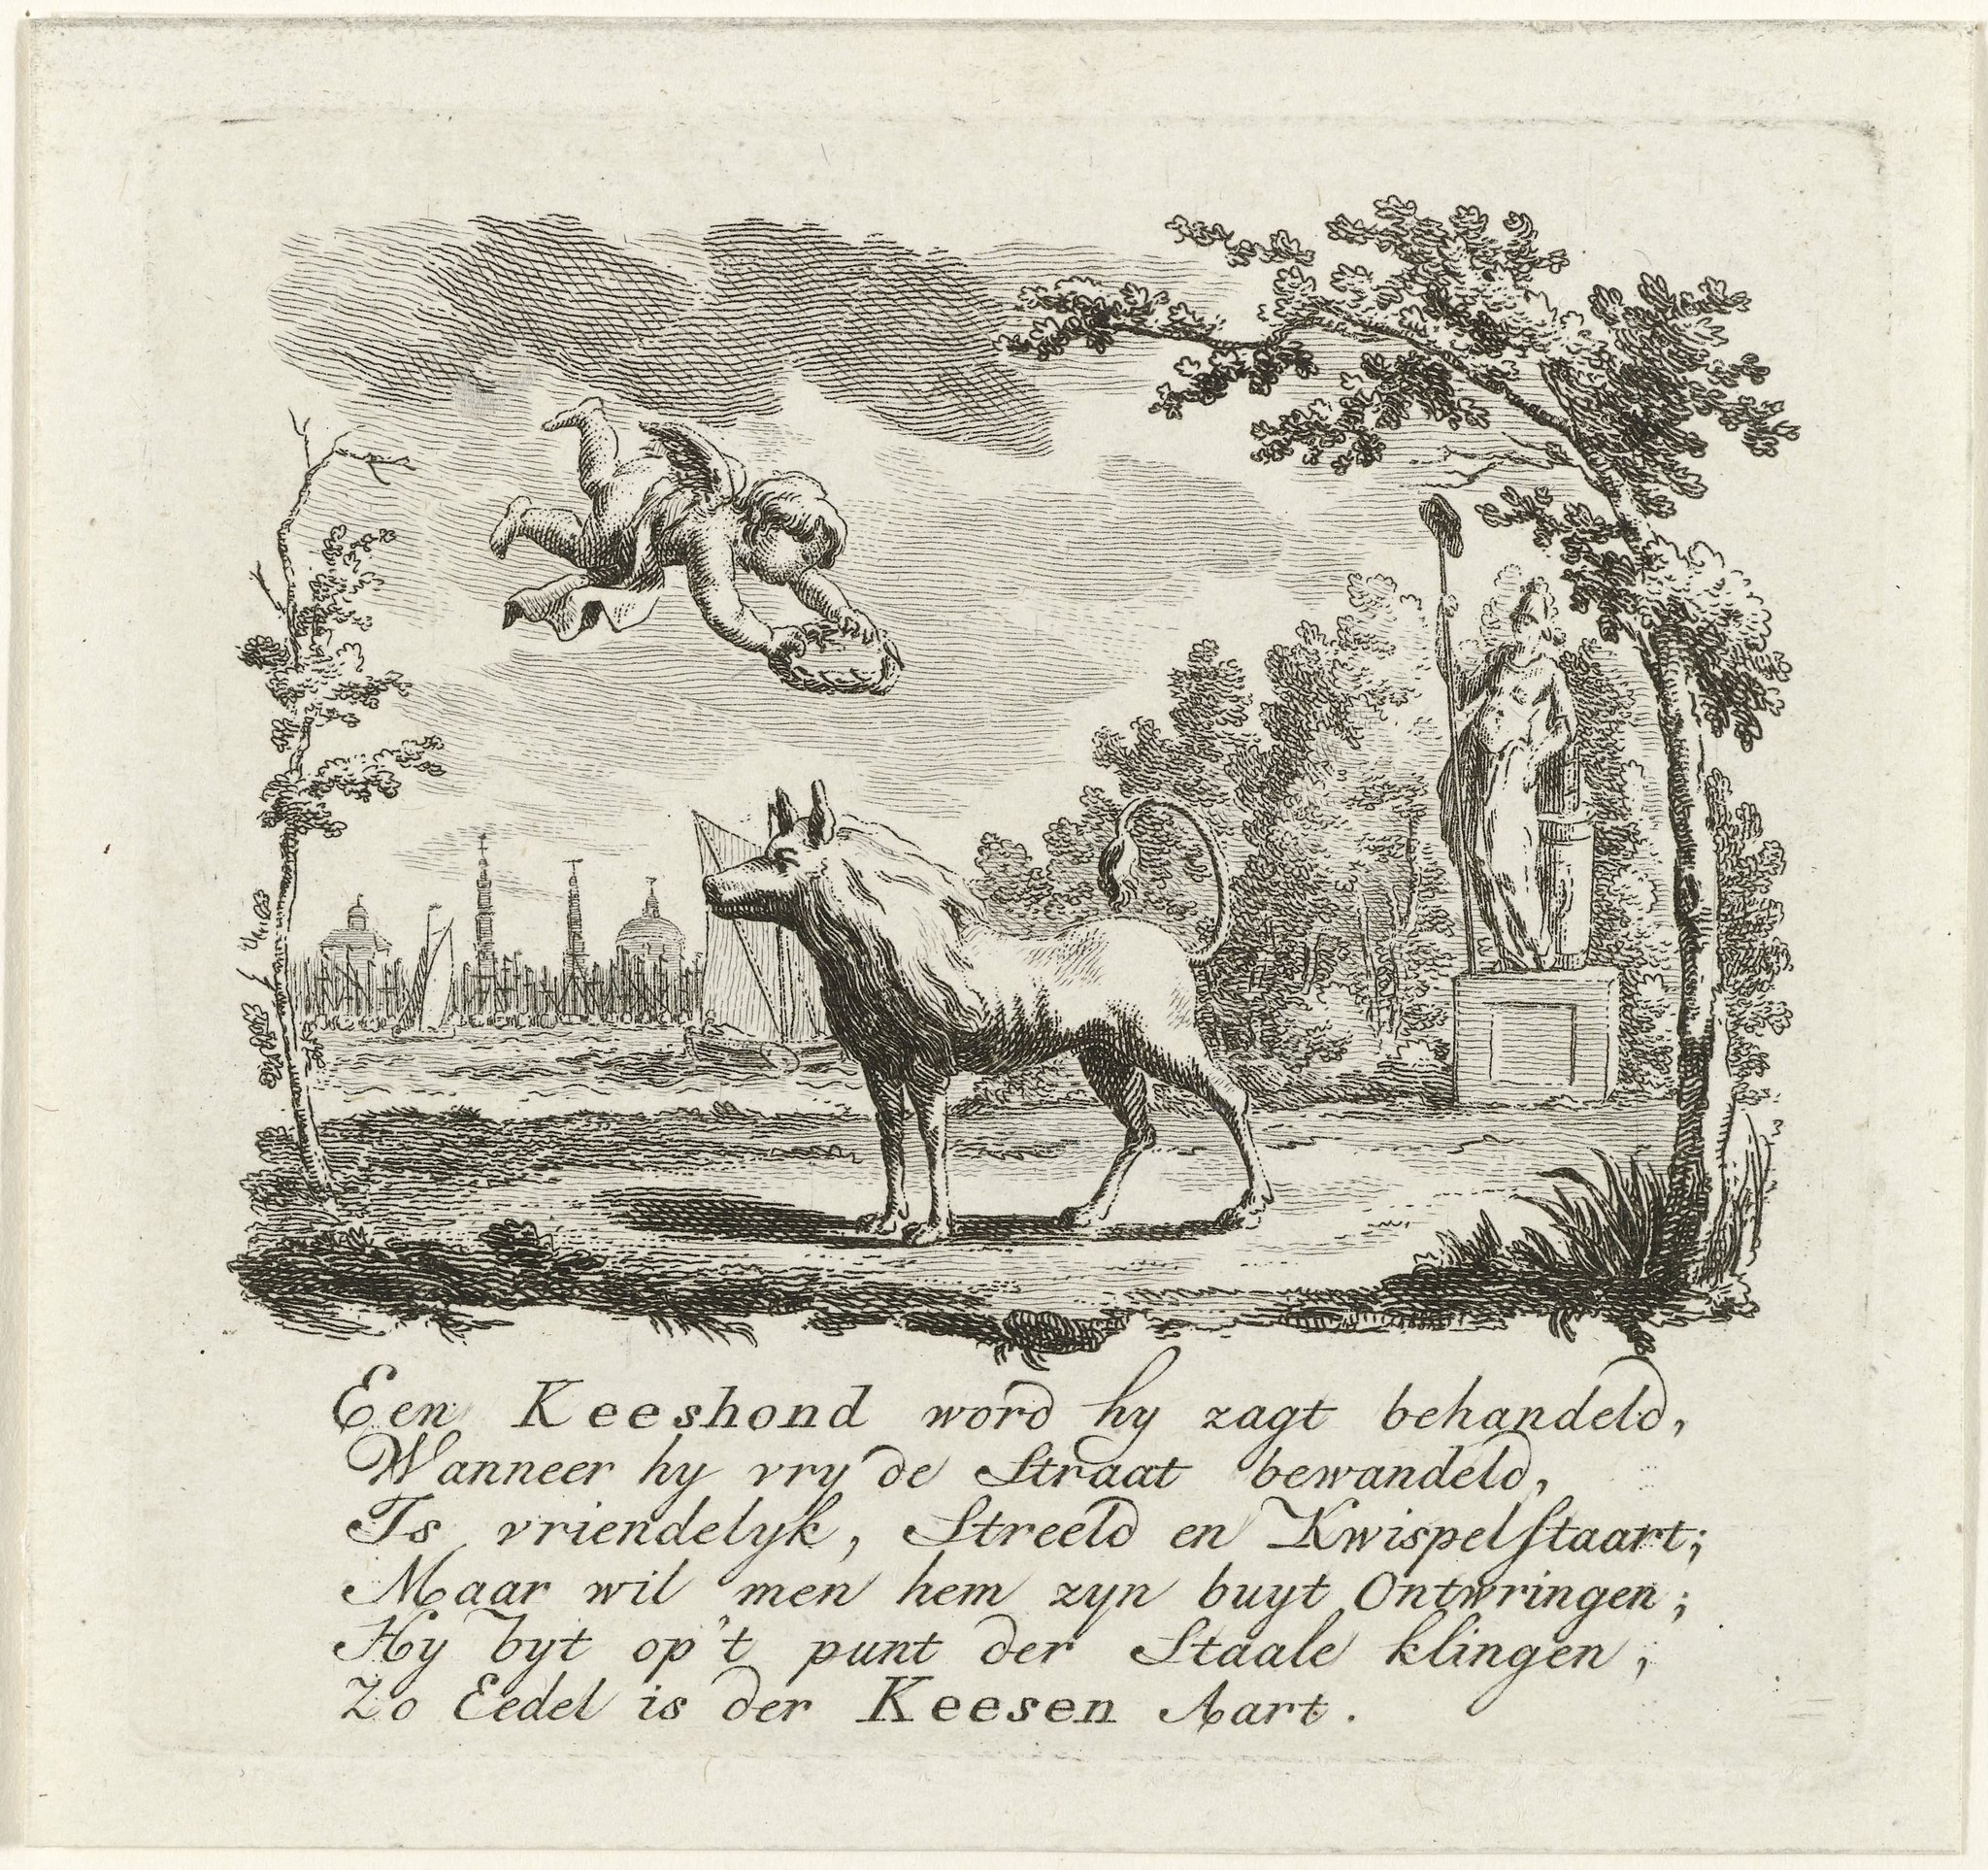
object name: print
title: Keeshond door een engel gekroond, ca. 1787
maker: Anonymous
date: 1787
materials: paper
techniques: etching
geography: northern netherlands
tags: dog, patriots (1780-1795)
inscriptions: collector's mark: Lugt 2228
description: Allegorische voorstelling waarin een keeshond (patriot) door een engel met een lauwerkrans wordt gekroond, ca. 1787. Op de achtergrond een standbeeld van de Vrijheid en het profiel van een stad. In het onderschrift een zesregelig vers.